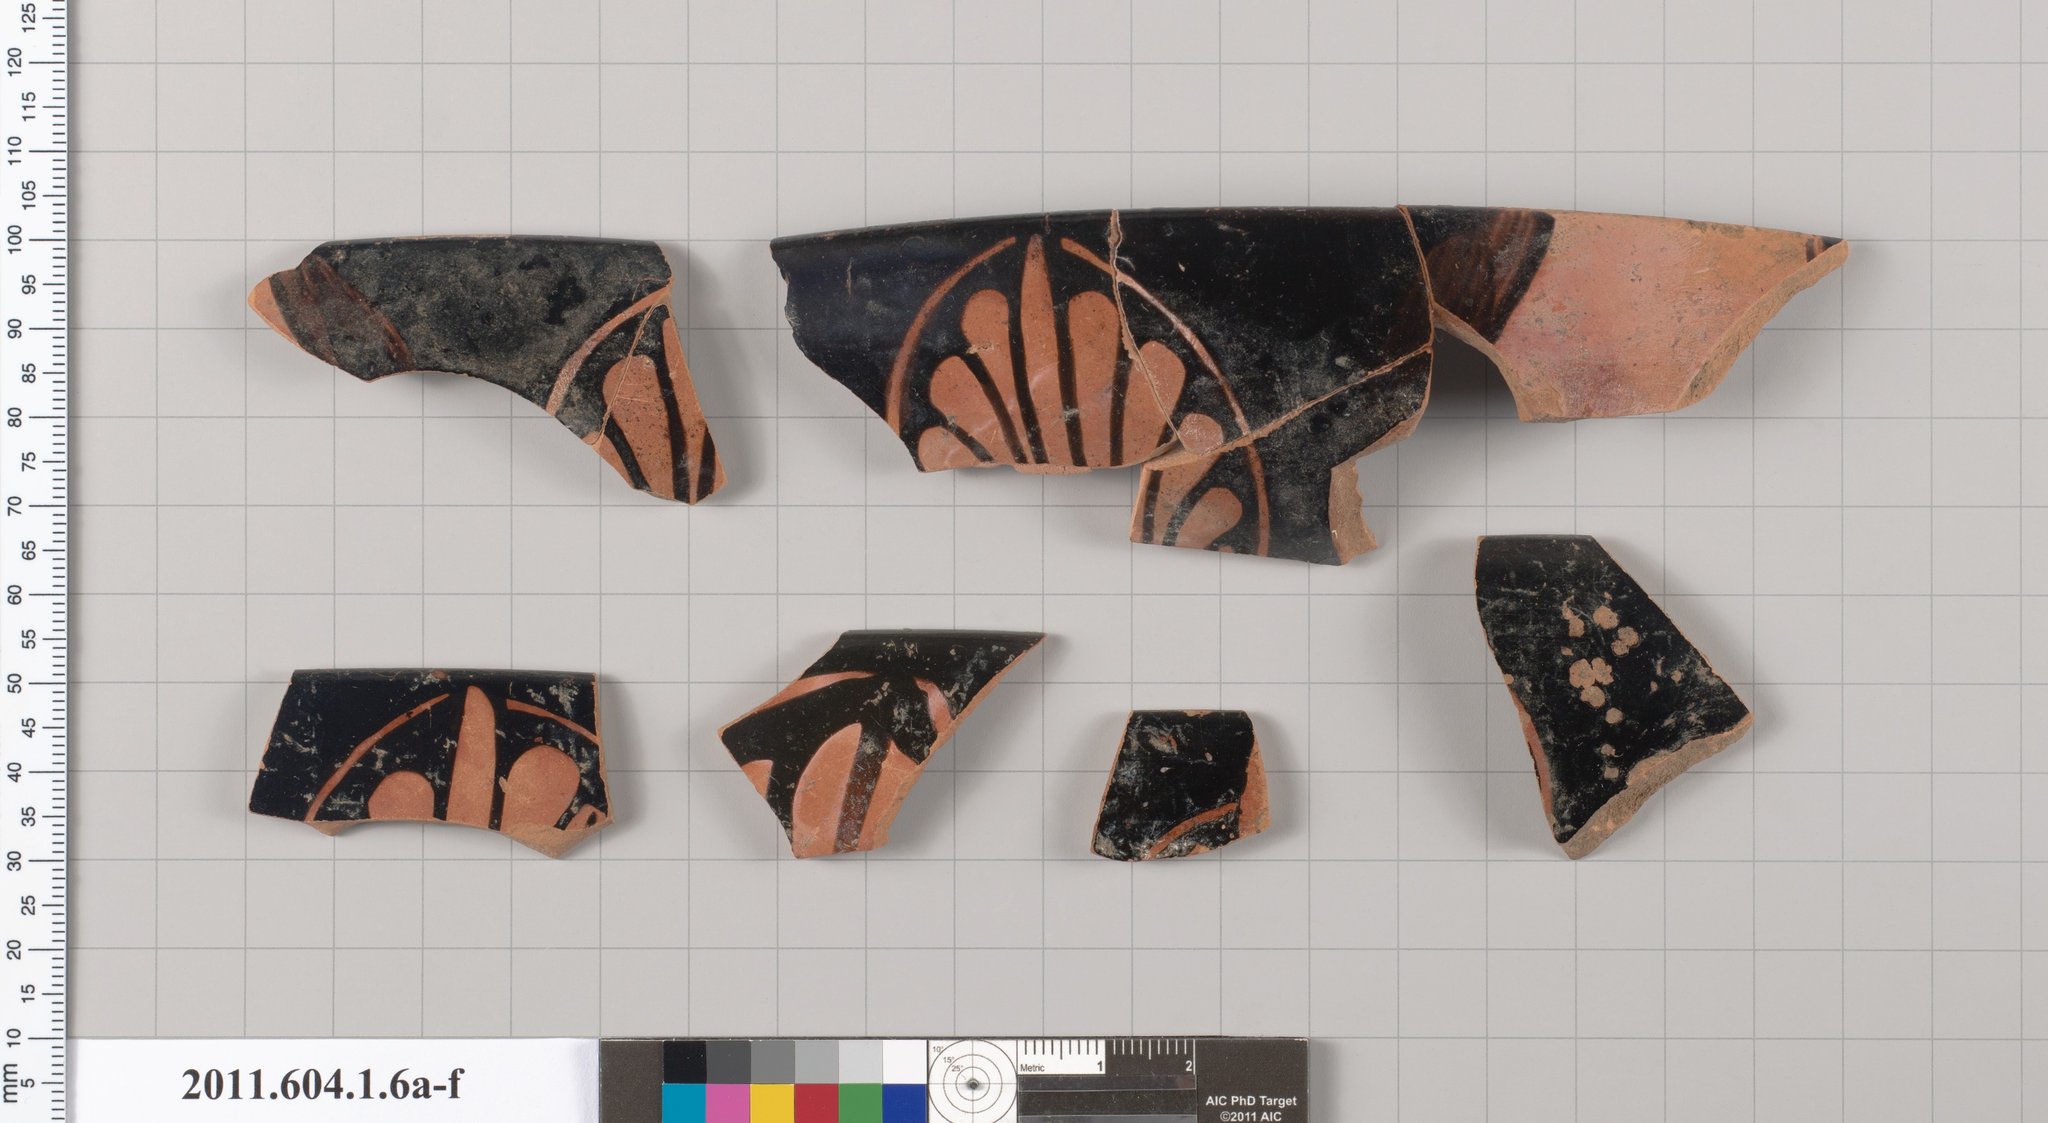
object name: kylix fragment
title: Terracotta rim fragments of a kylix (drinking cup)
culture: greek, attic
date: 467-435 BCE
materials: terracotta